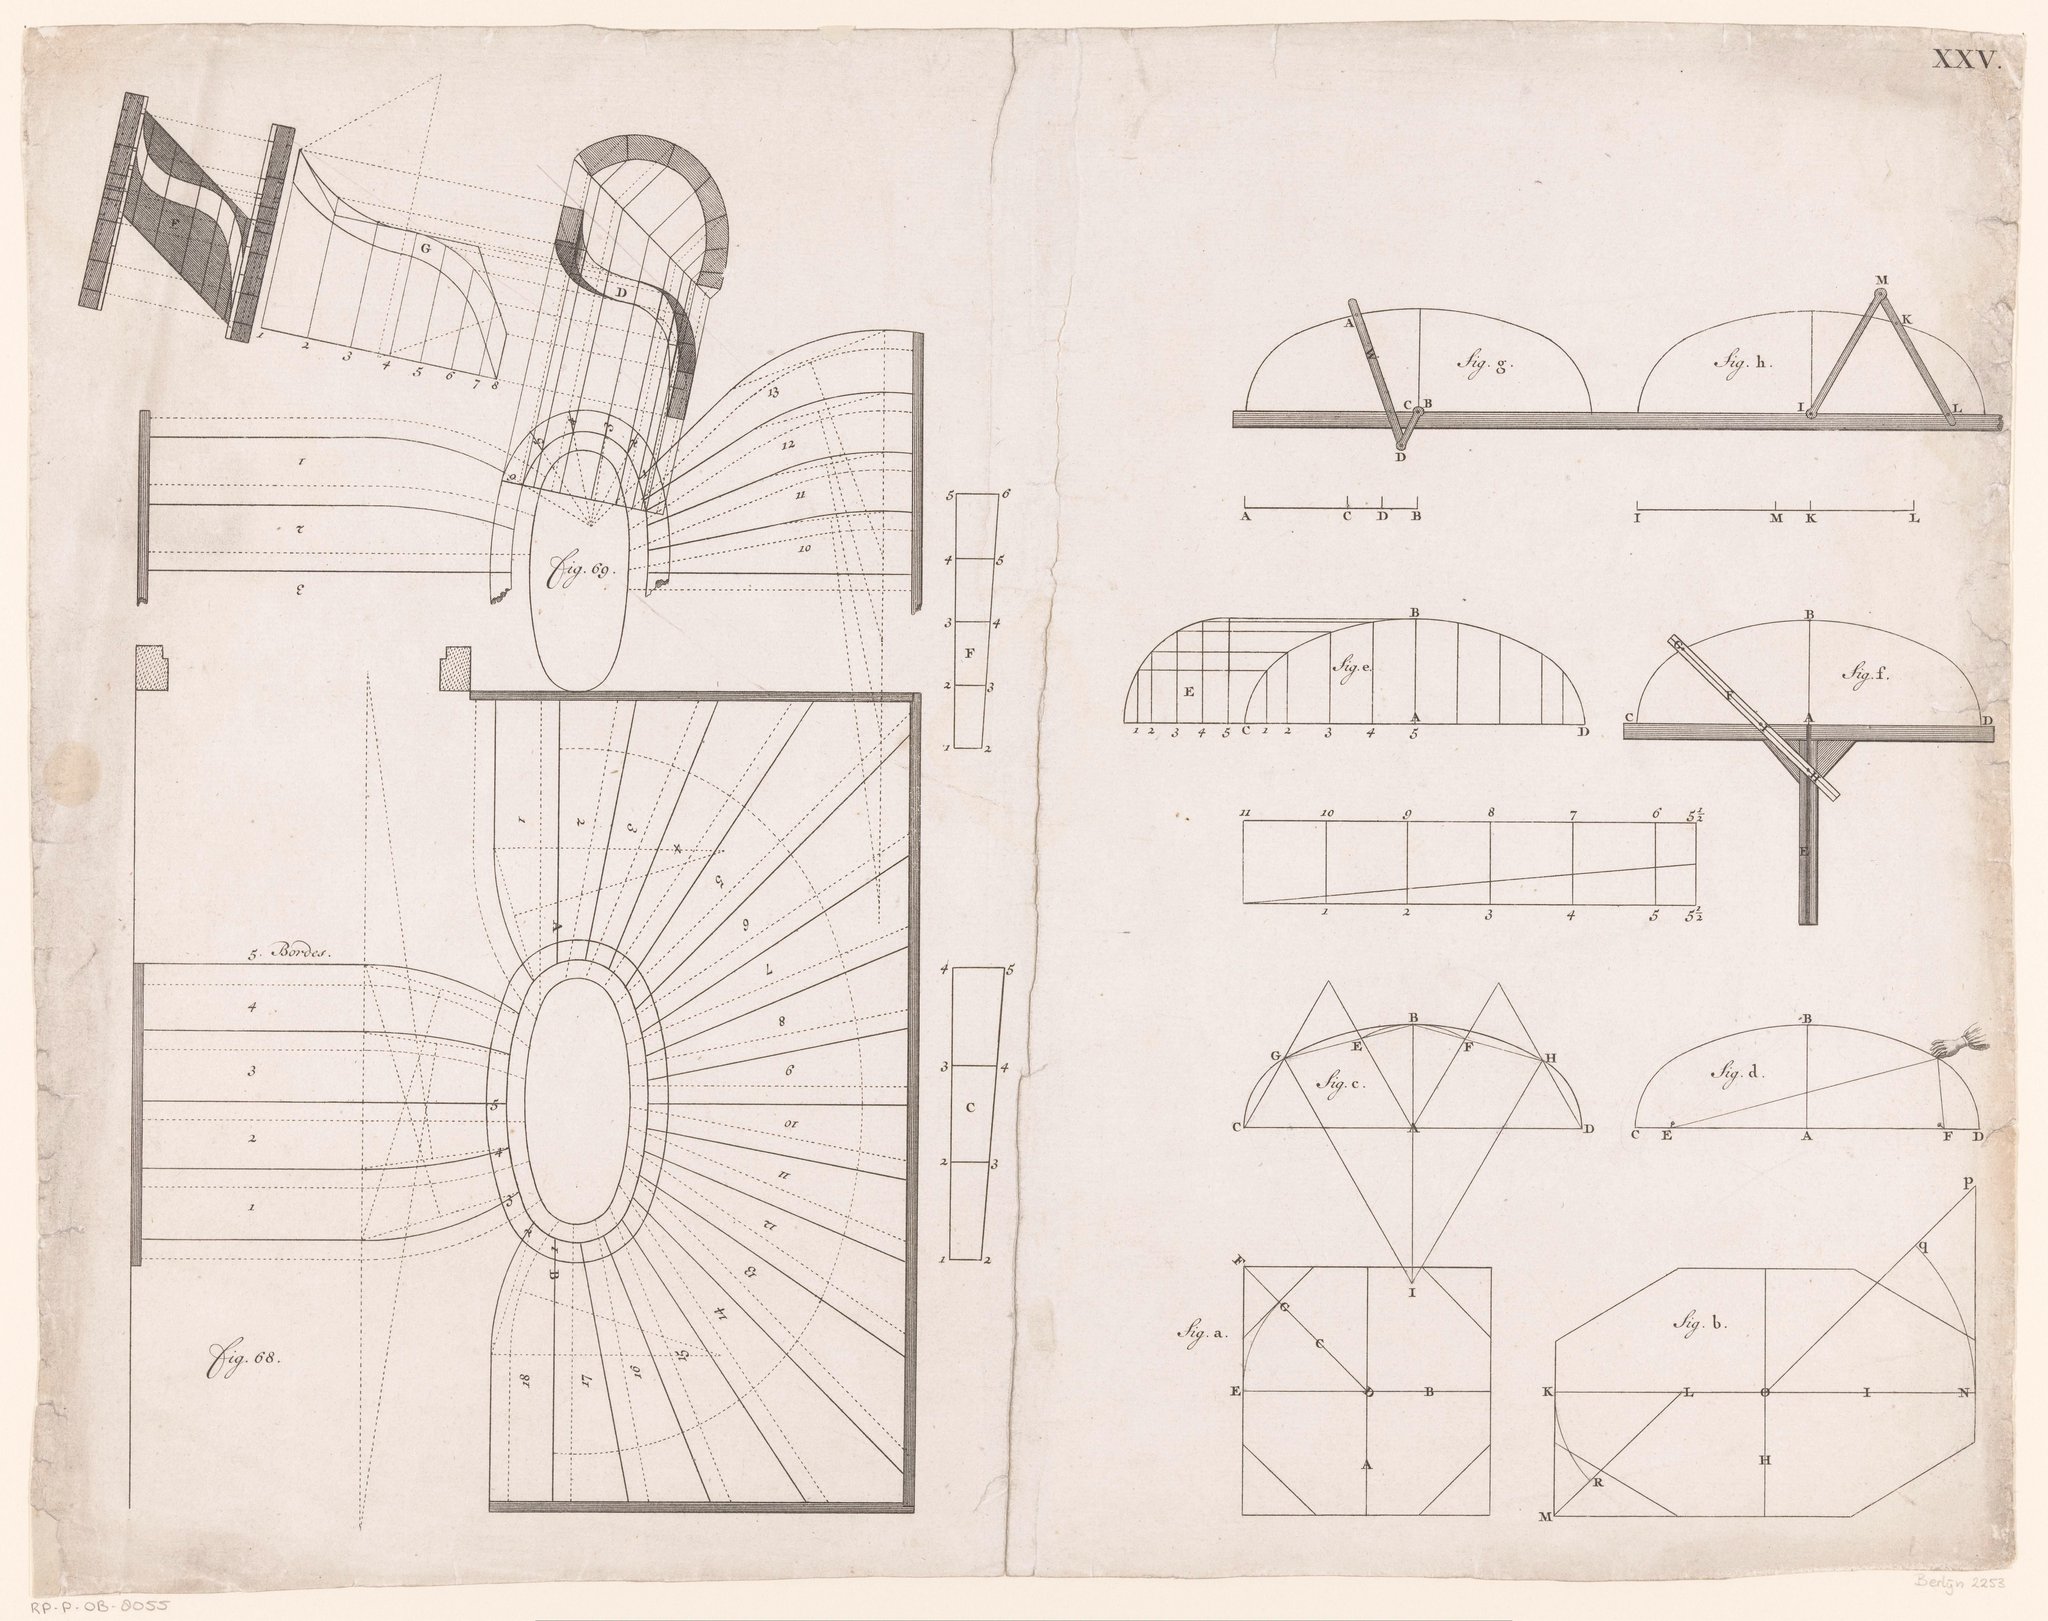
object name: print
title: Theatrum Machinarum Universale; Of Nieuwe Algemeende Bouwkunde (...)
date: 1739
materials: paper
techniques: engraving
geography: amsterdam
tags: drawing (mathematics), staircase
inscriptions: collector's mark: Lugt 2228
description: Technische tekeningen van een trappen met bordessen (nummers 68 en 69). Bovenaanzichten.